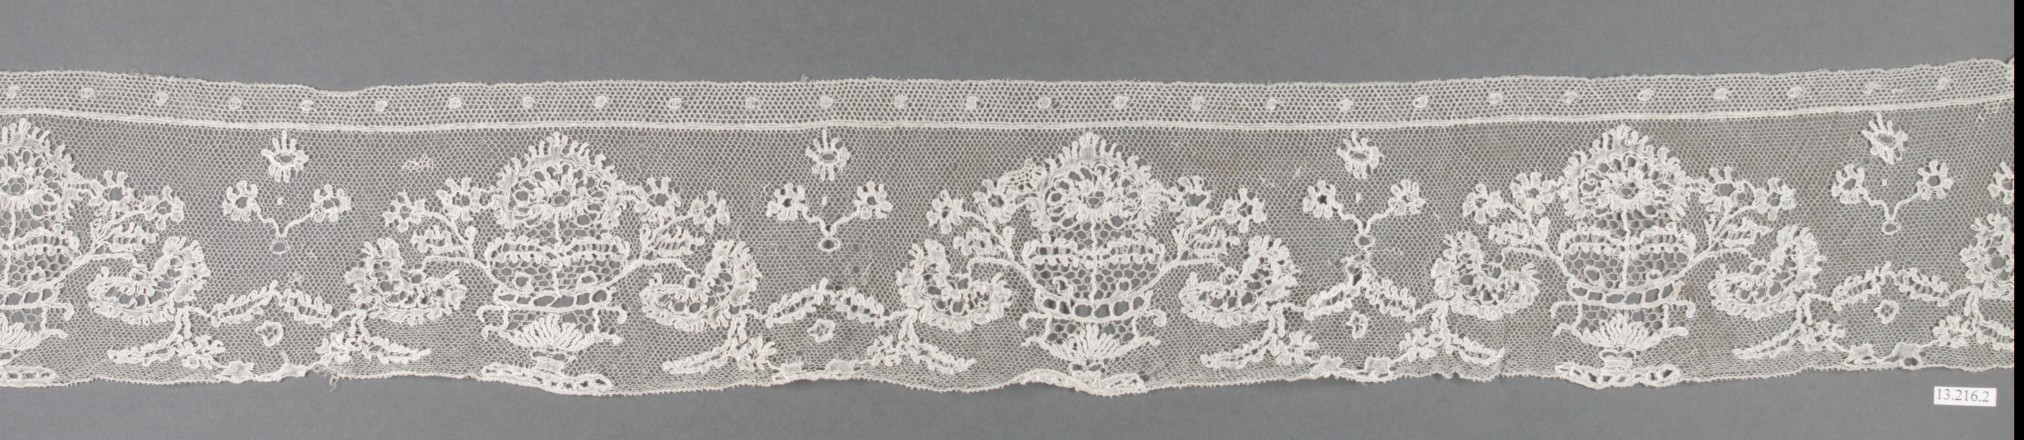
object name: border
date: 1701-1800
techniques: lace